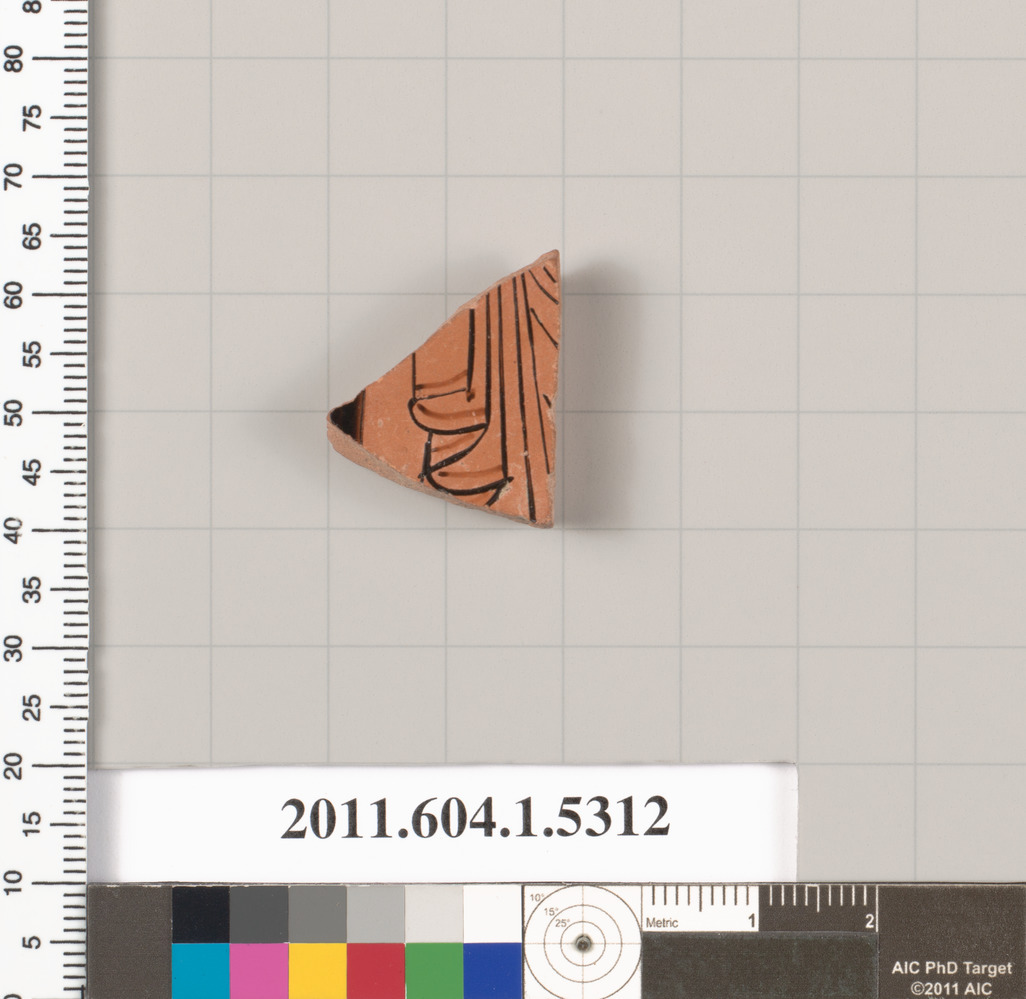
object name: kylix fragment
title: Terracotta fragment of a kylix (drinking cup)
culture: greek, attic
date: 510-490 BCE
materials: terracotta